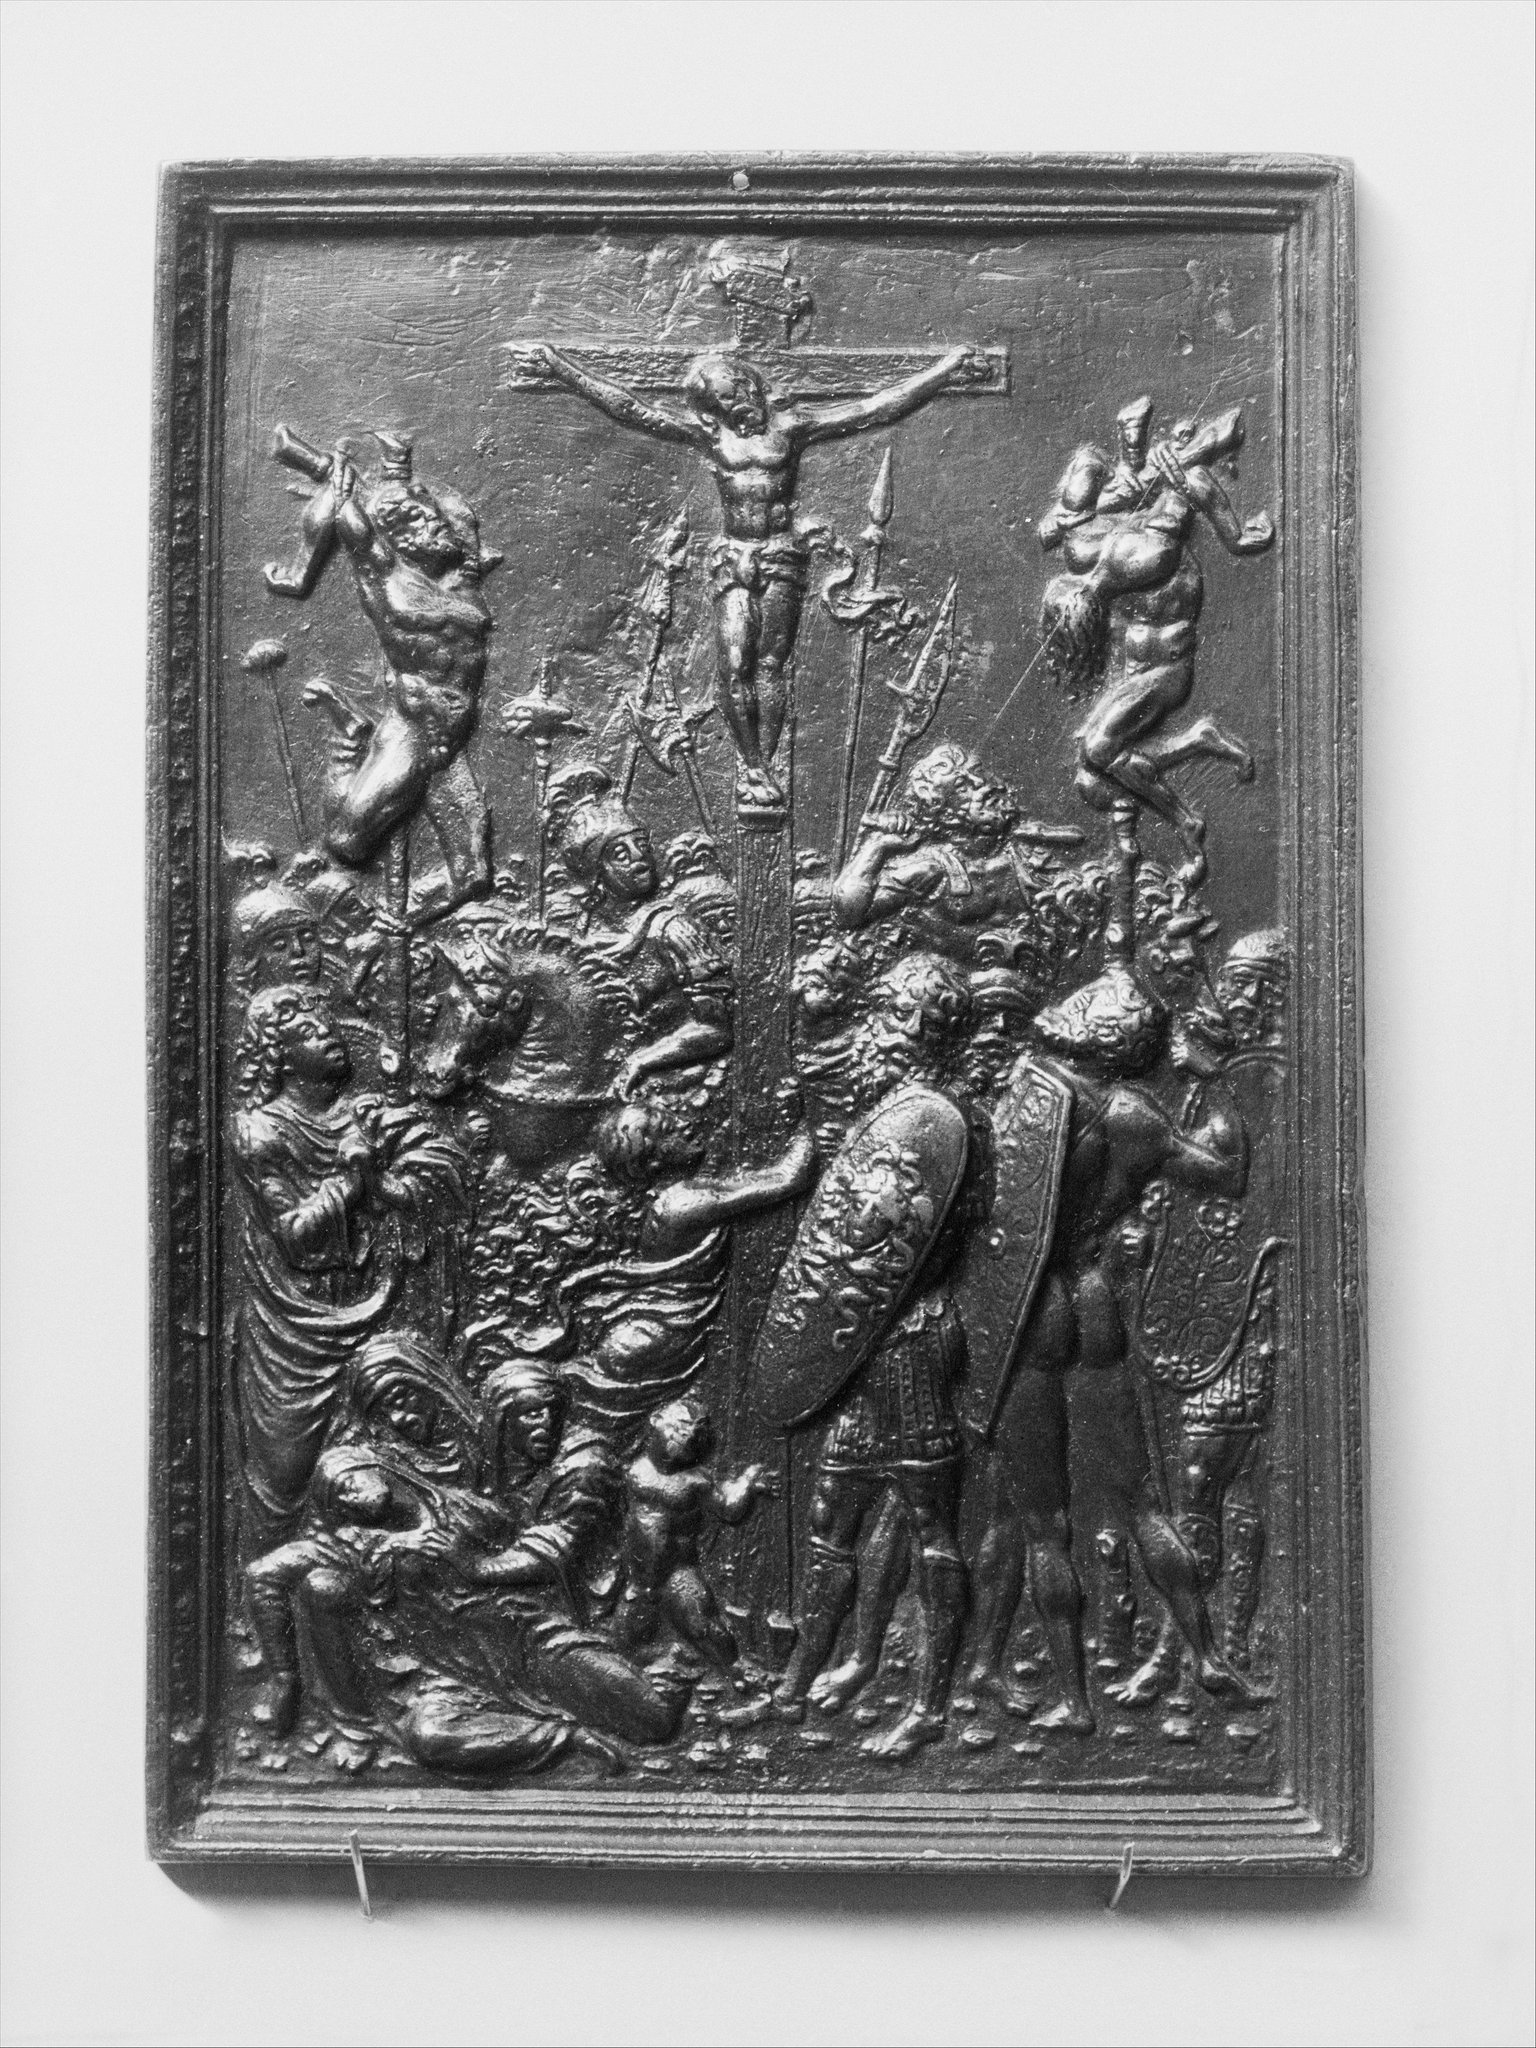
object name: plaquette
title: The Crucifixion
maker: moderno (galeazzo mondella)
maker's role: artist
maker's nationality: italian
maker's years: 1467-1528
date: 1467-1500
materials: bronze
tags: men,christ,crucifixion